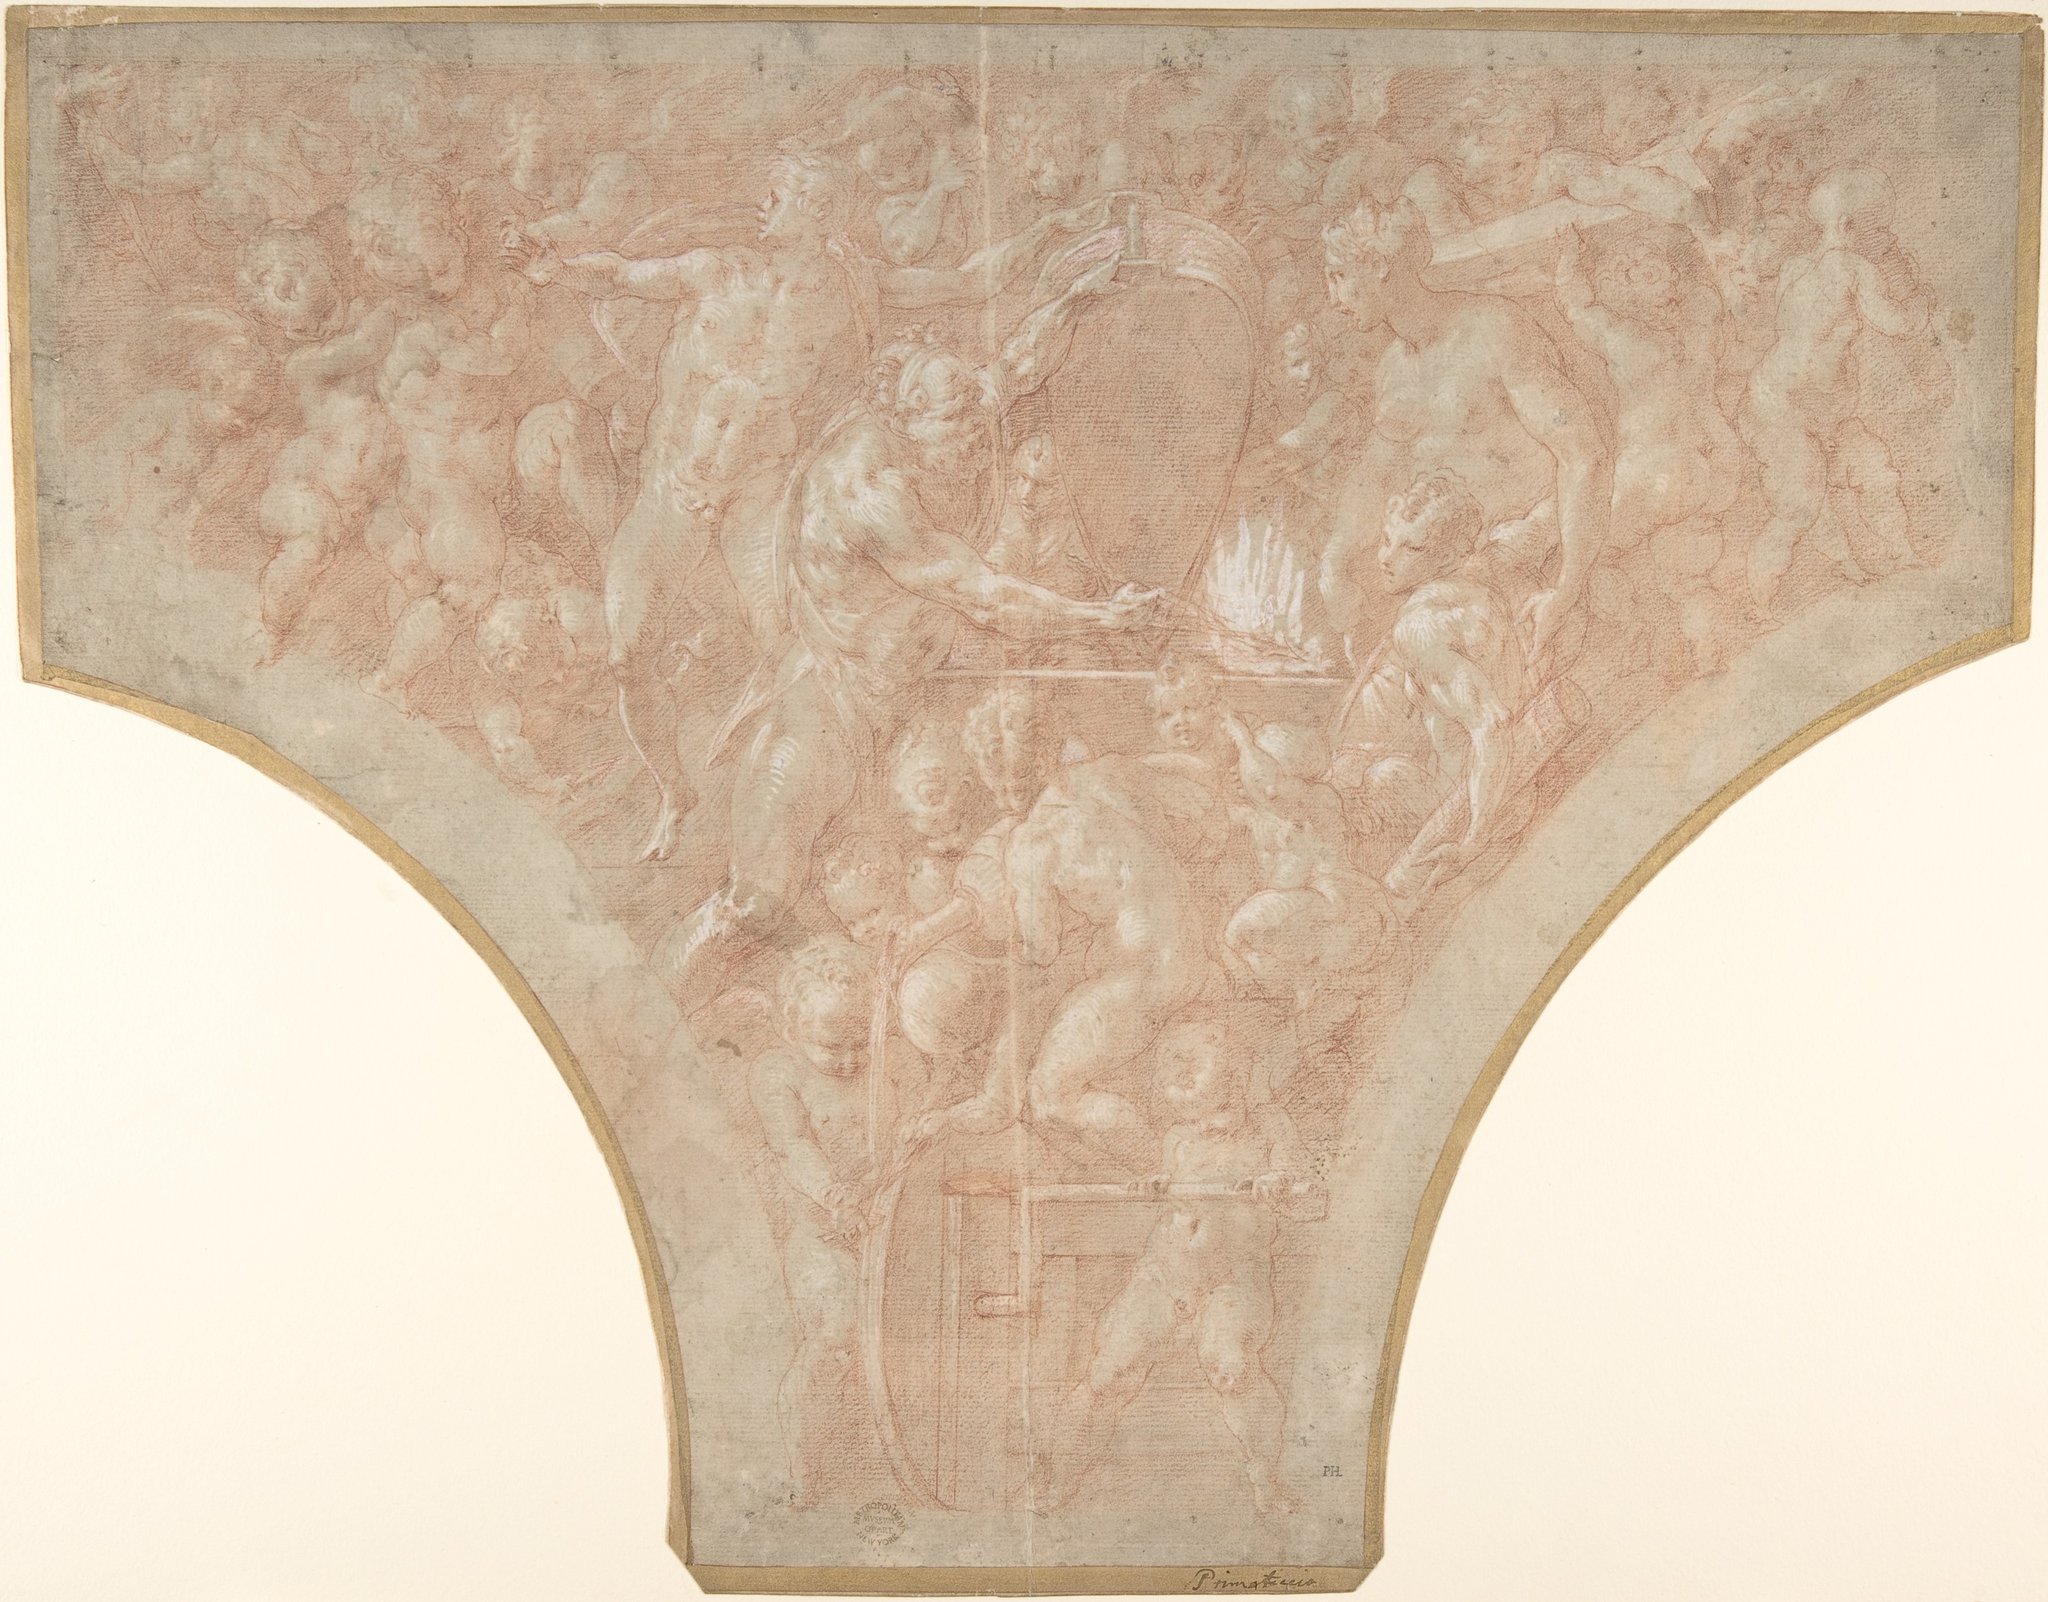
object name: drawing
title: Vulcan Forging the Darts of Cupid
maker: francesco primaticcio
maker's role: artist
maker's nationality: italian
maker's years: 1504-1570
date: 1552-1556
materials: chalk, gouache, paper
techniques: highlighting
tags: cupid,vulcan